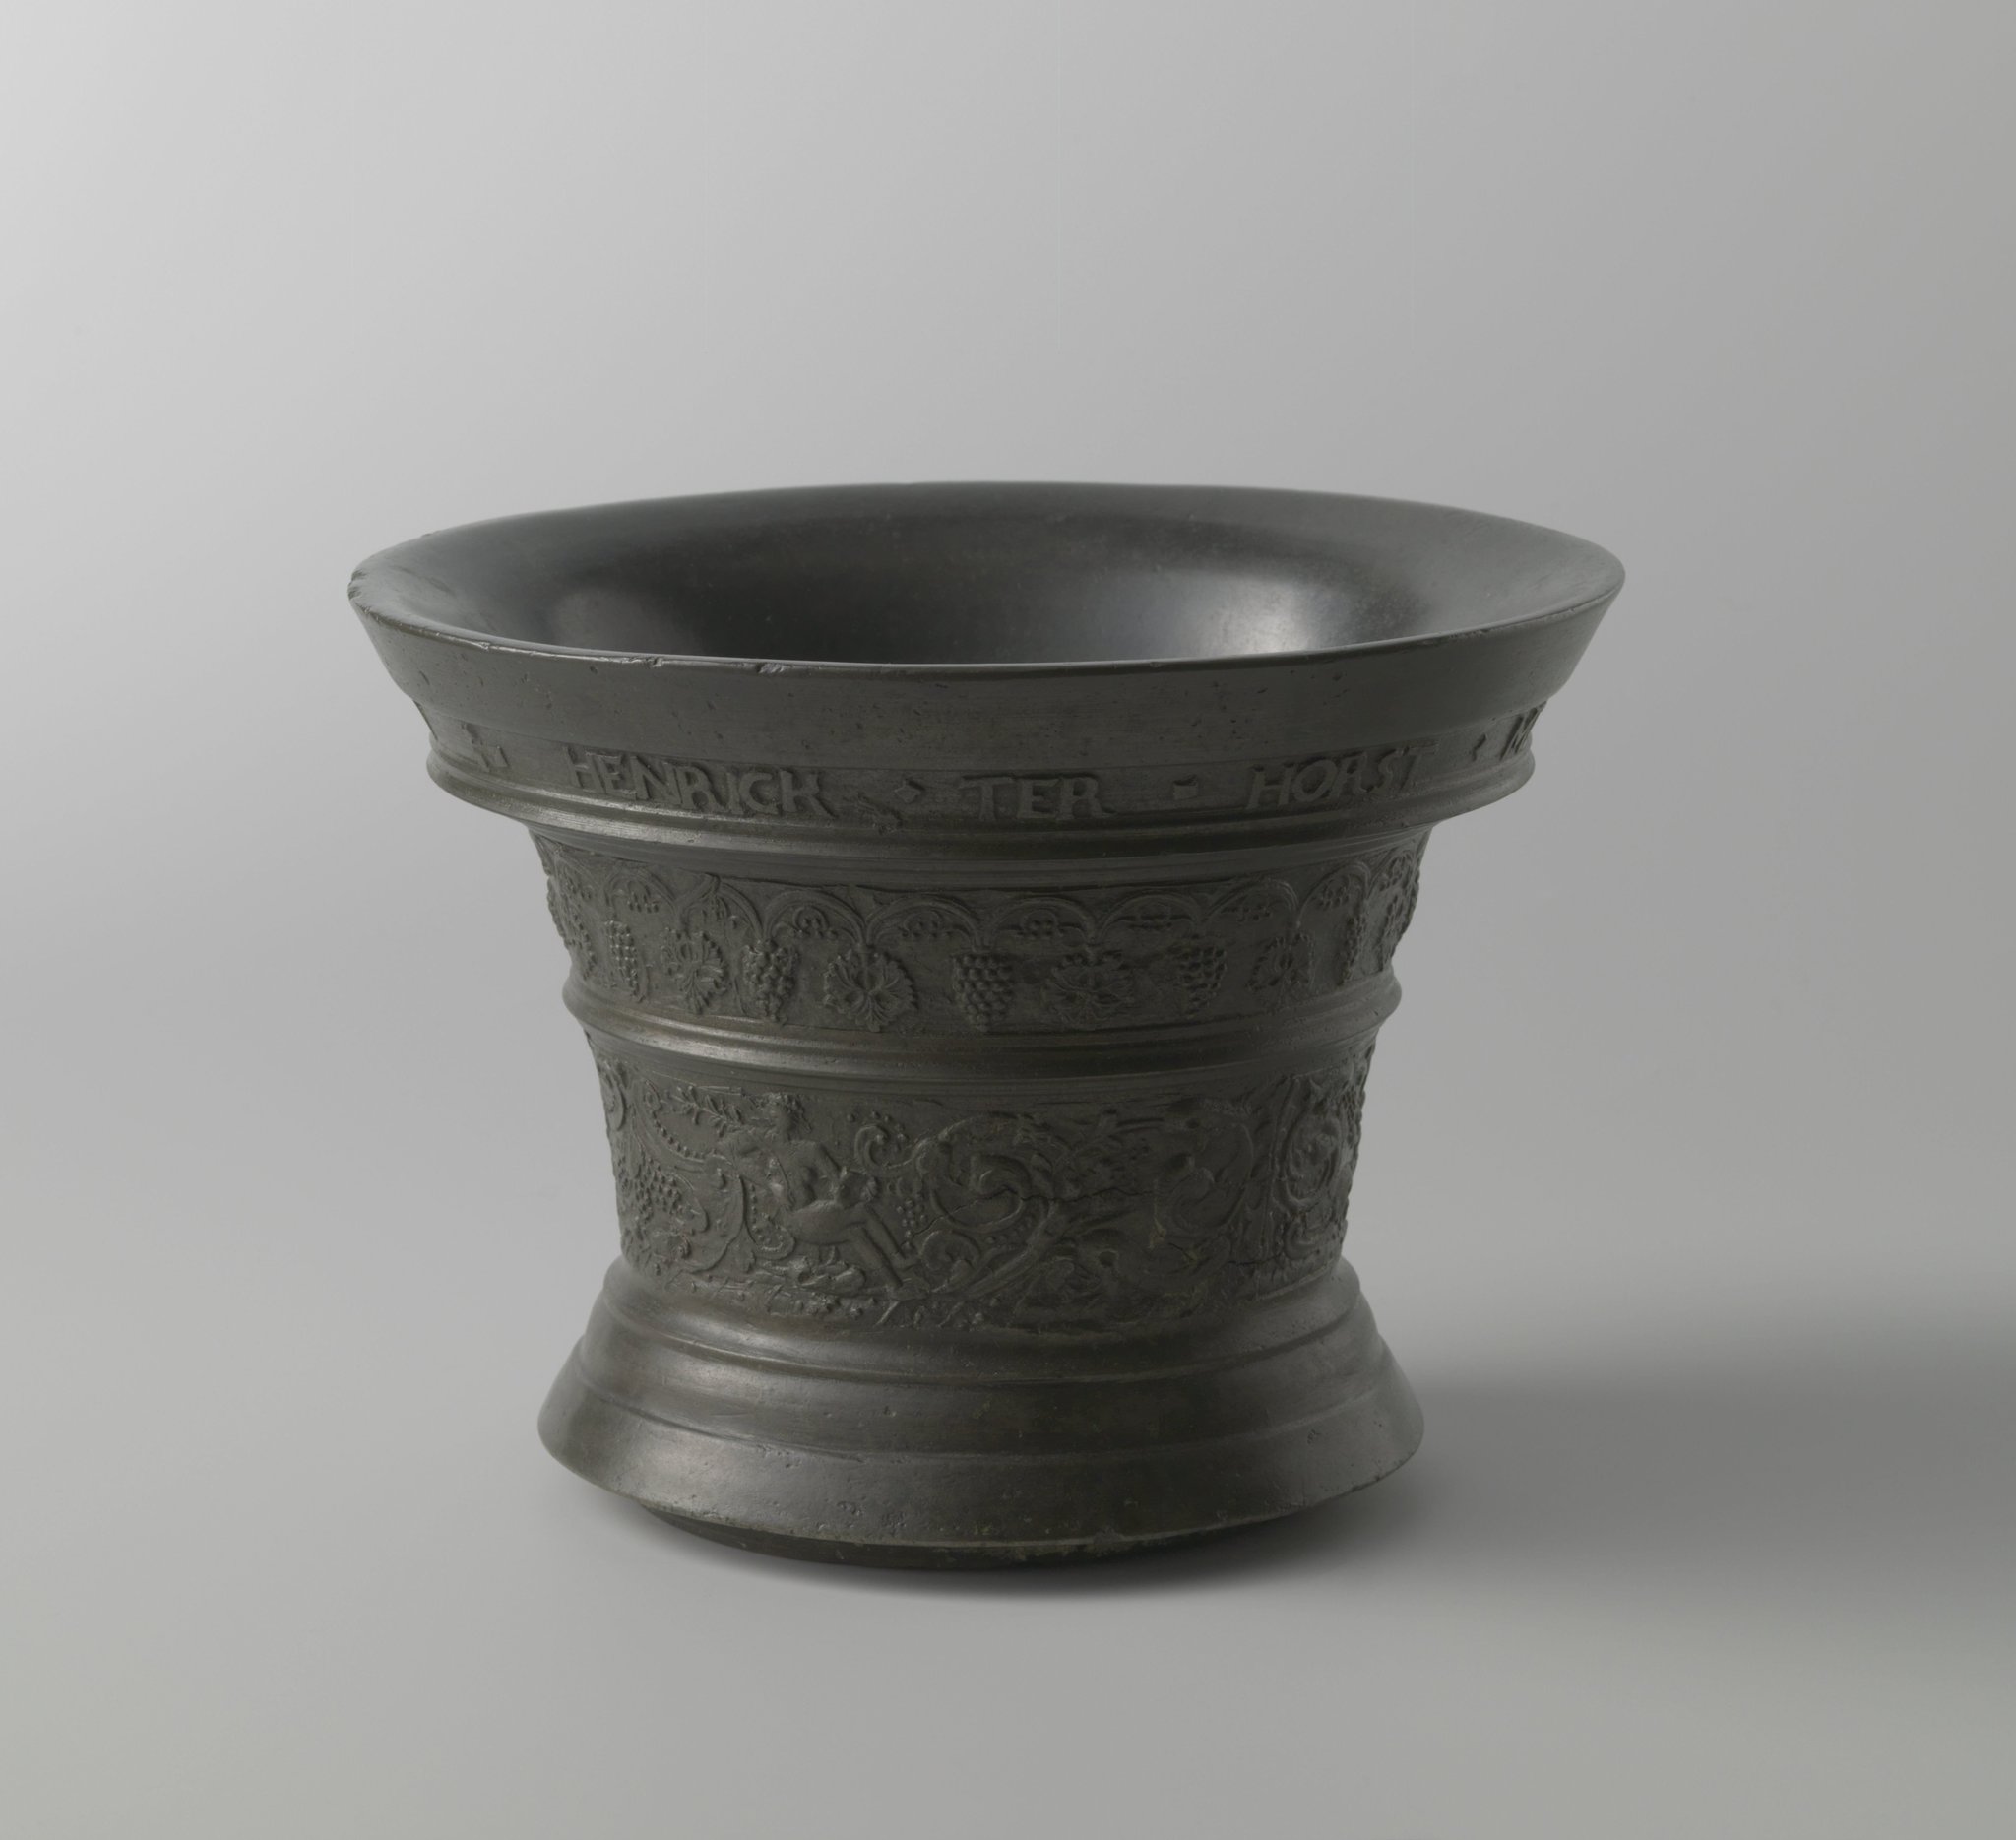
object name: mortar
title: Vijzel met opschrift HENRICK TER HORST ME FECIT DAVENTRIAE ANNO 1631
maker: henrick ter horst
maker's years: 1600-1680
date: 1631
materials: bronze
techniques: casting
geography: deventer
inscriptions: inscription: ‘HENRICK.TER.HORST.ME.FECIT.DAVENTRIAE.ANNO.1631.’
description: De gegoten ronde vijzel verbreedt zich naar boven toe, heeft een hoge uitkragende en geprofileerde rand en een geprofileerde voet, welke hoger is aangebracht dan de onderkant van het voorwerp. Op de rand in Latijnse majuskels het opschrift HENRICK TER HORST ME FECIT DAVENTRIAE ANNO 1631 met interpuncties bestaande uit een ruit (zeven keer) en uit drie ruitjes. De wand wordt boven het midden in tweeën gedeeld door een scherp geprofileerde rib. Het bovenste fries is opgebouwd uit driepasbogen, waaraan om en om druiventros en wingerdblad hangen. Het onderste fries vertoont door een cartouche omgeven druiventrossen, geflankeerd door twee naakte vrouwenfiguren met o.a. een tak in de hand. De cartouche loopt uit in gestileerd rankenwerk van twee voluten, waarin o.a. druiventrossen zijn opgenomen. Het gehele motief wordt nog geen twee keer herhaald. Aan de onderkant wordt het fries afgesloten door een gestileerde gewonden parel- en koordrand.